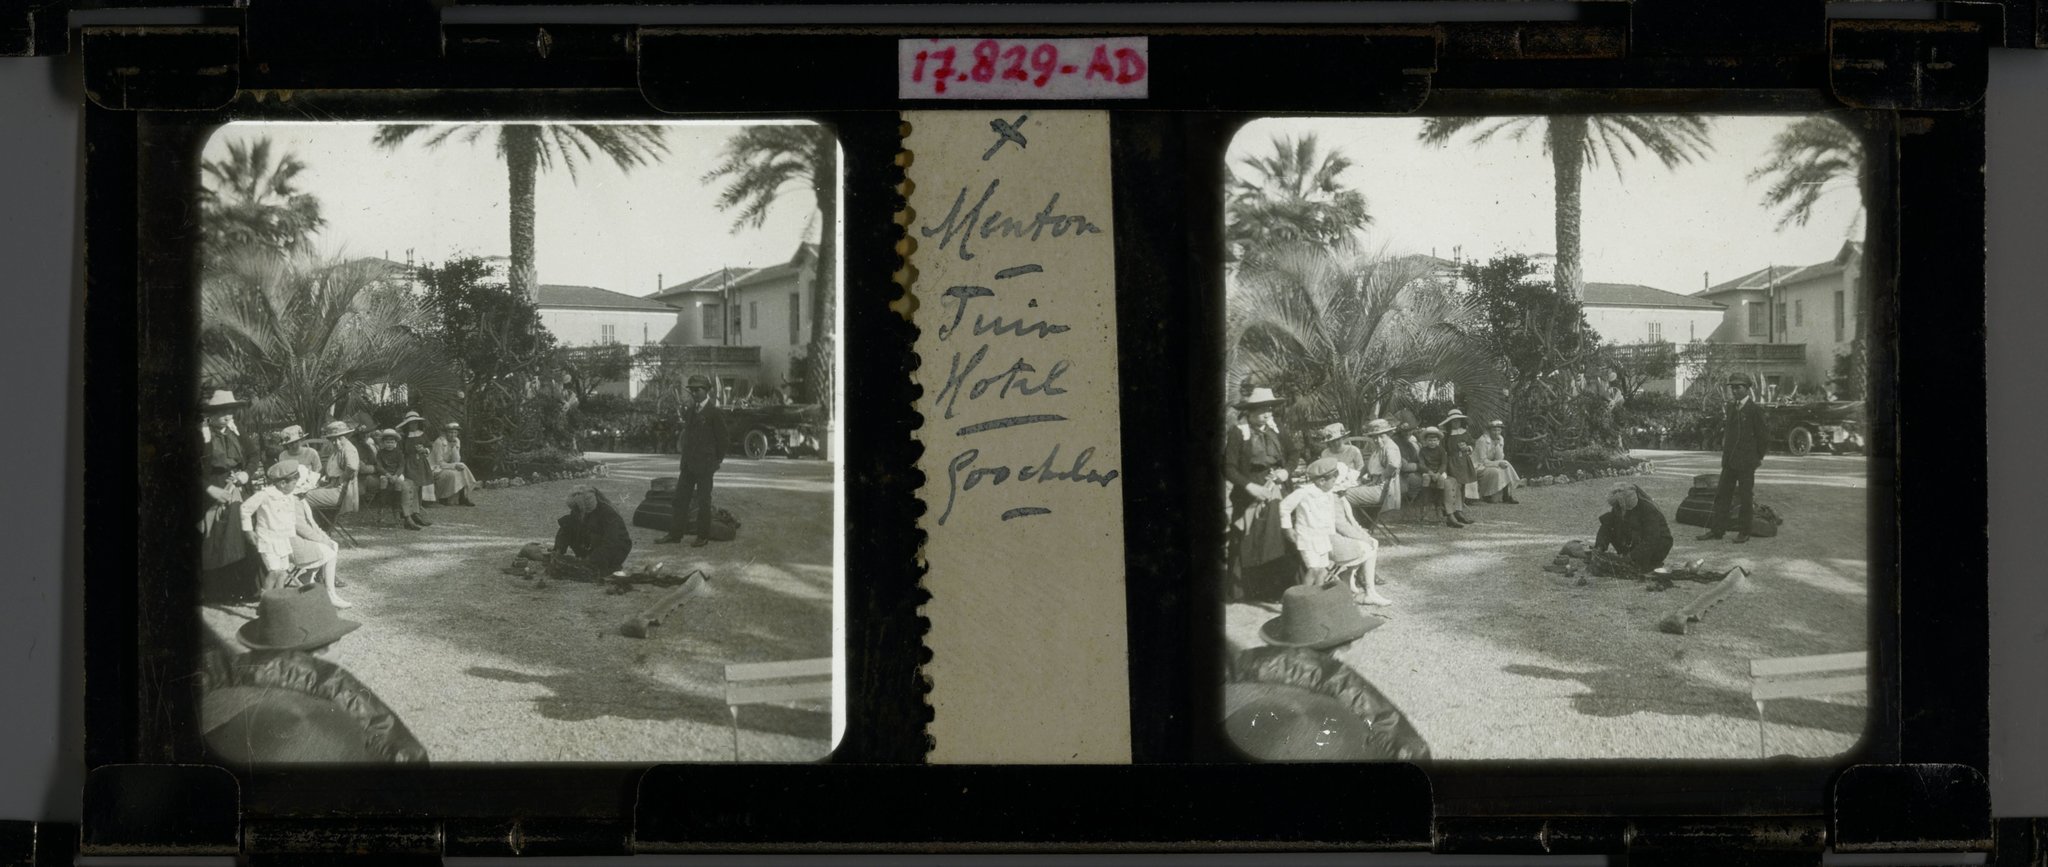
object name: stereoscopic photograph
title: Vrouwen en kinderen kijken naar een goochelaar in de tuin van een hotel, Menton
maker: Anonymous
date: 1920-1925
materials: glass, metal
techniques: slide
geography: menton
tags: garden, sorcerer, magician, wizard, warlock